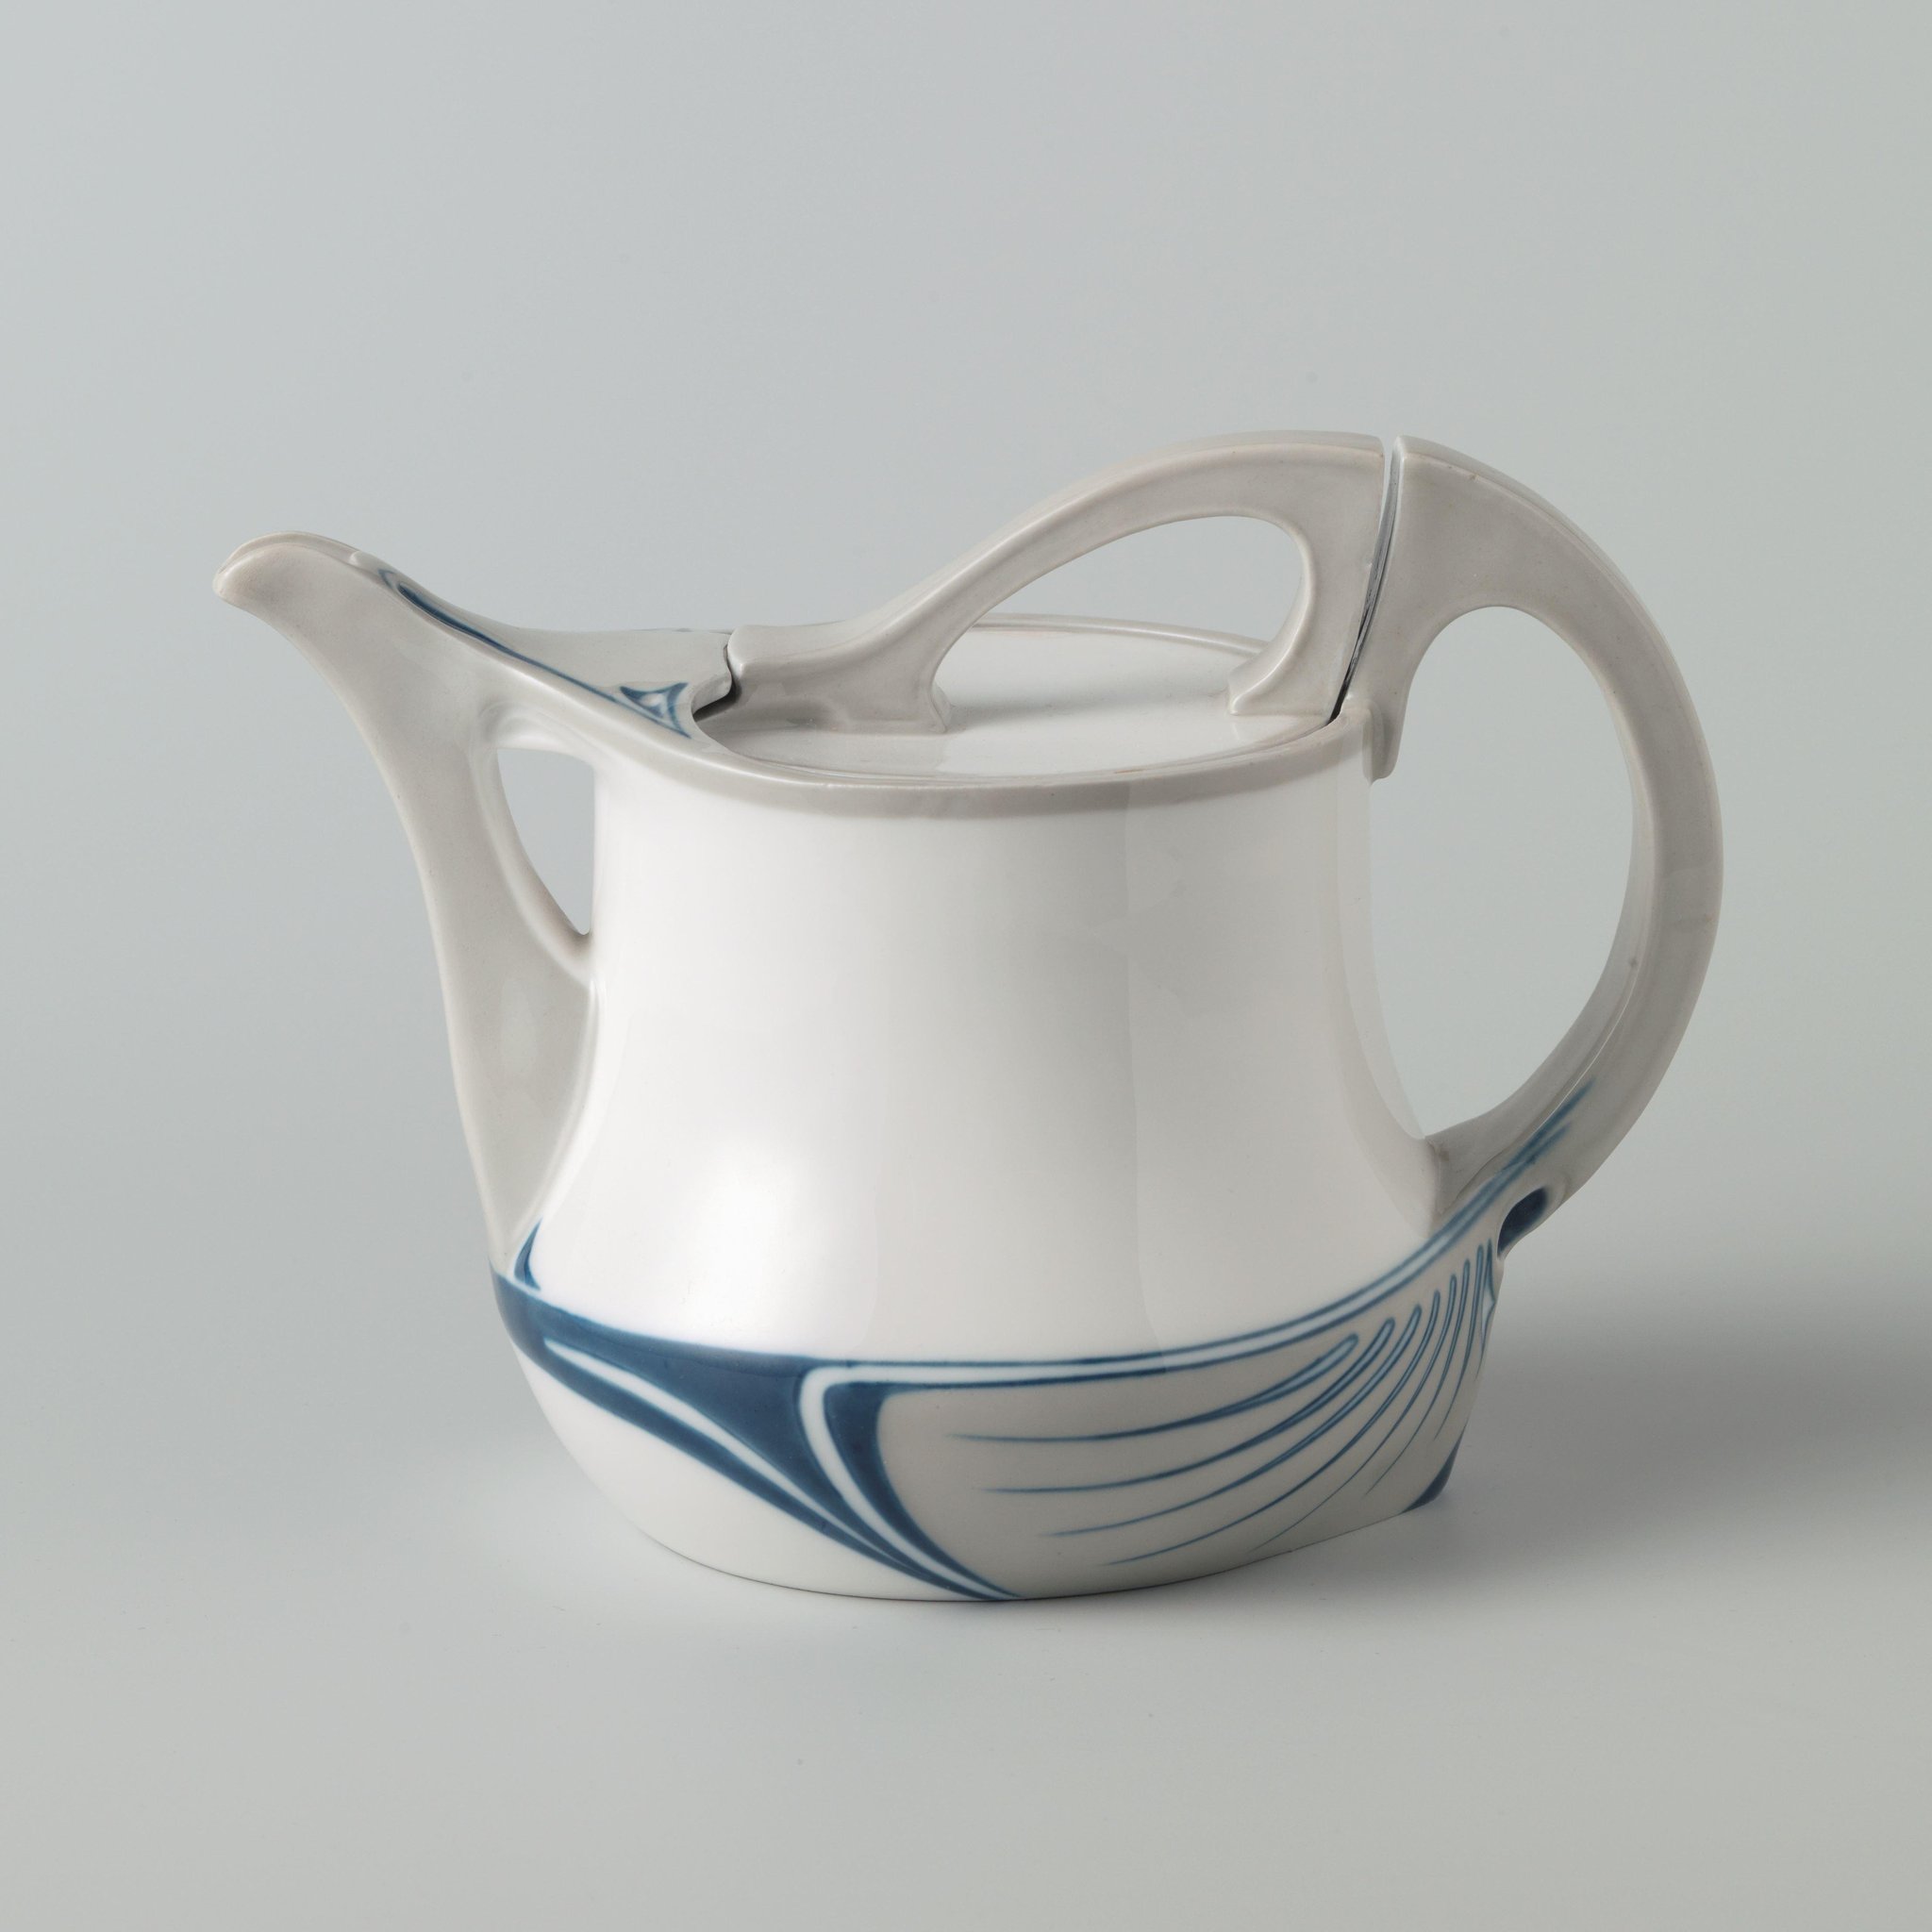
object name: lid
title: Deksel van theepot uit het koffie- en theeservies 'Saxonia'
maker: otto eduard voigt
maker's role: keramiekontwerper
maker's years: 1870-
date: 1904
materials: porcelain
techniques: painted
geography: meissen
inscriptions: mark: ‘87’, model number: ‘U 152’, factory mark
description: Deksel van theepot van porselein, beschilderd in blauw en grijs. De pot met deksel hoort bij het koffie- en theeservies Saxonia.